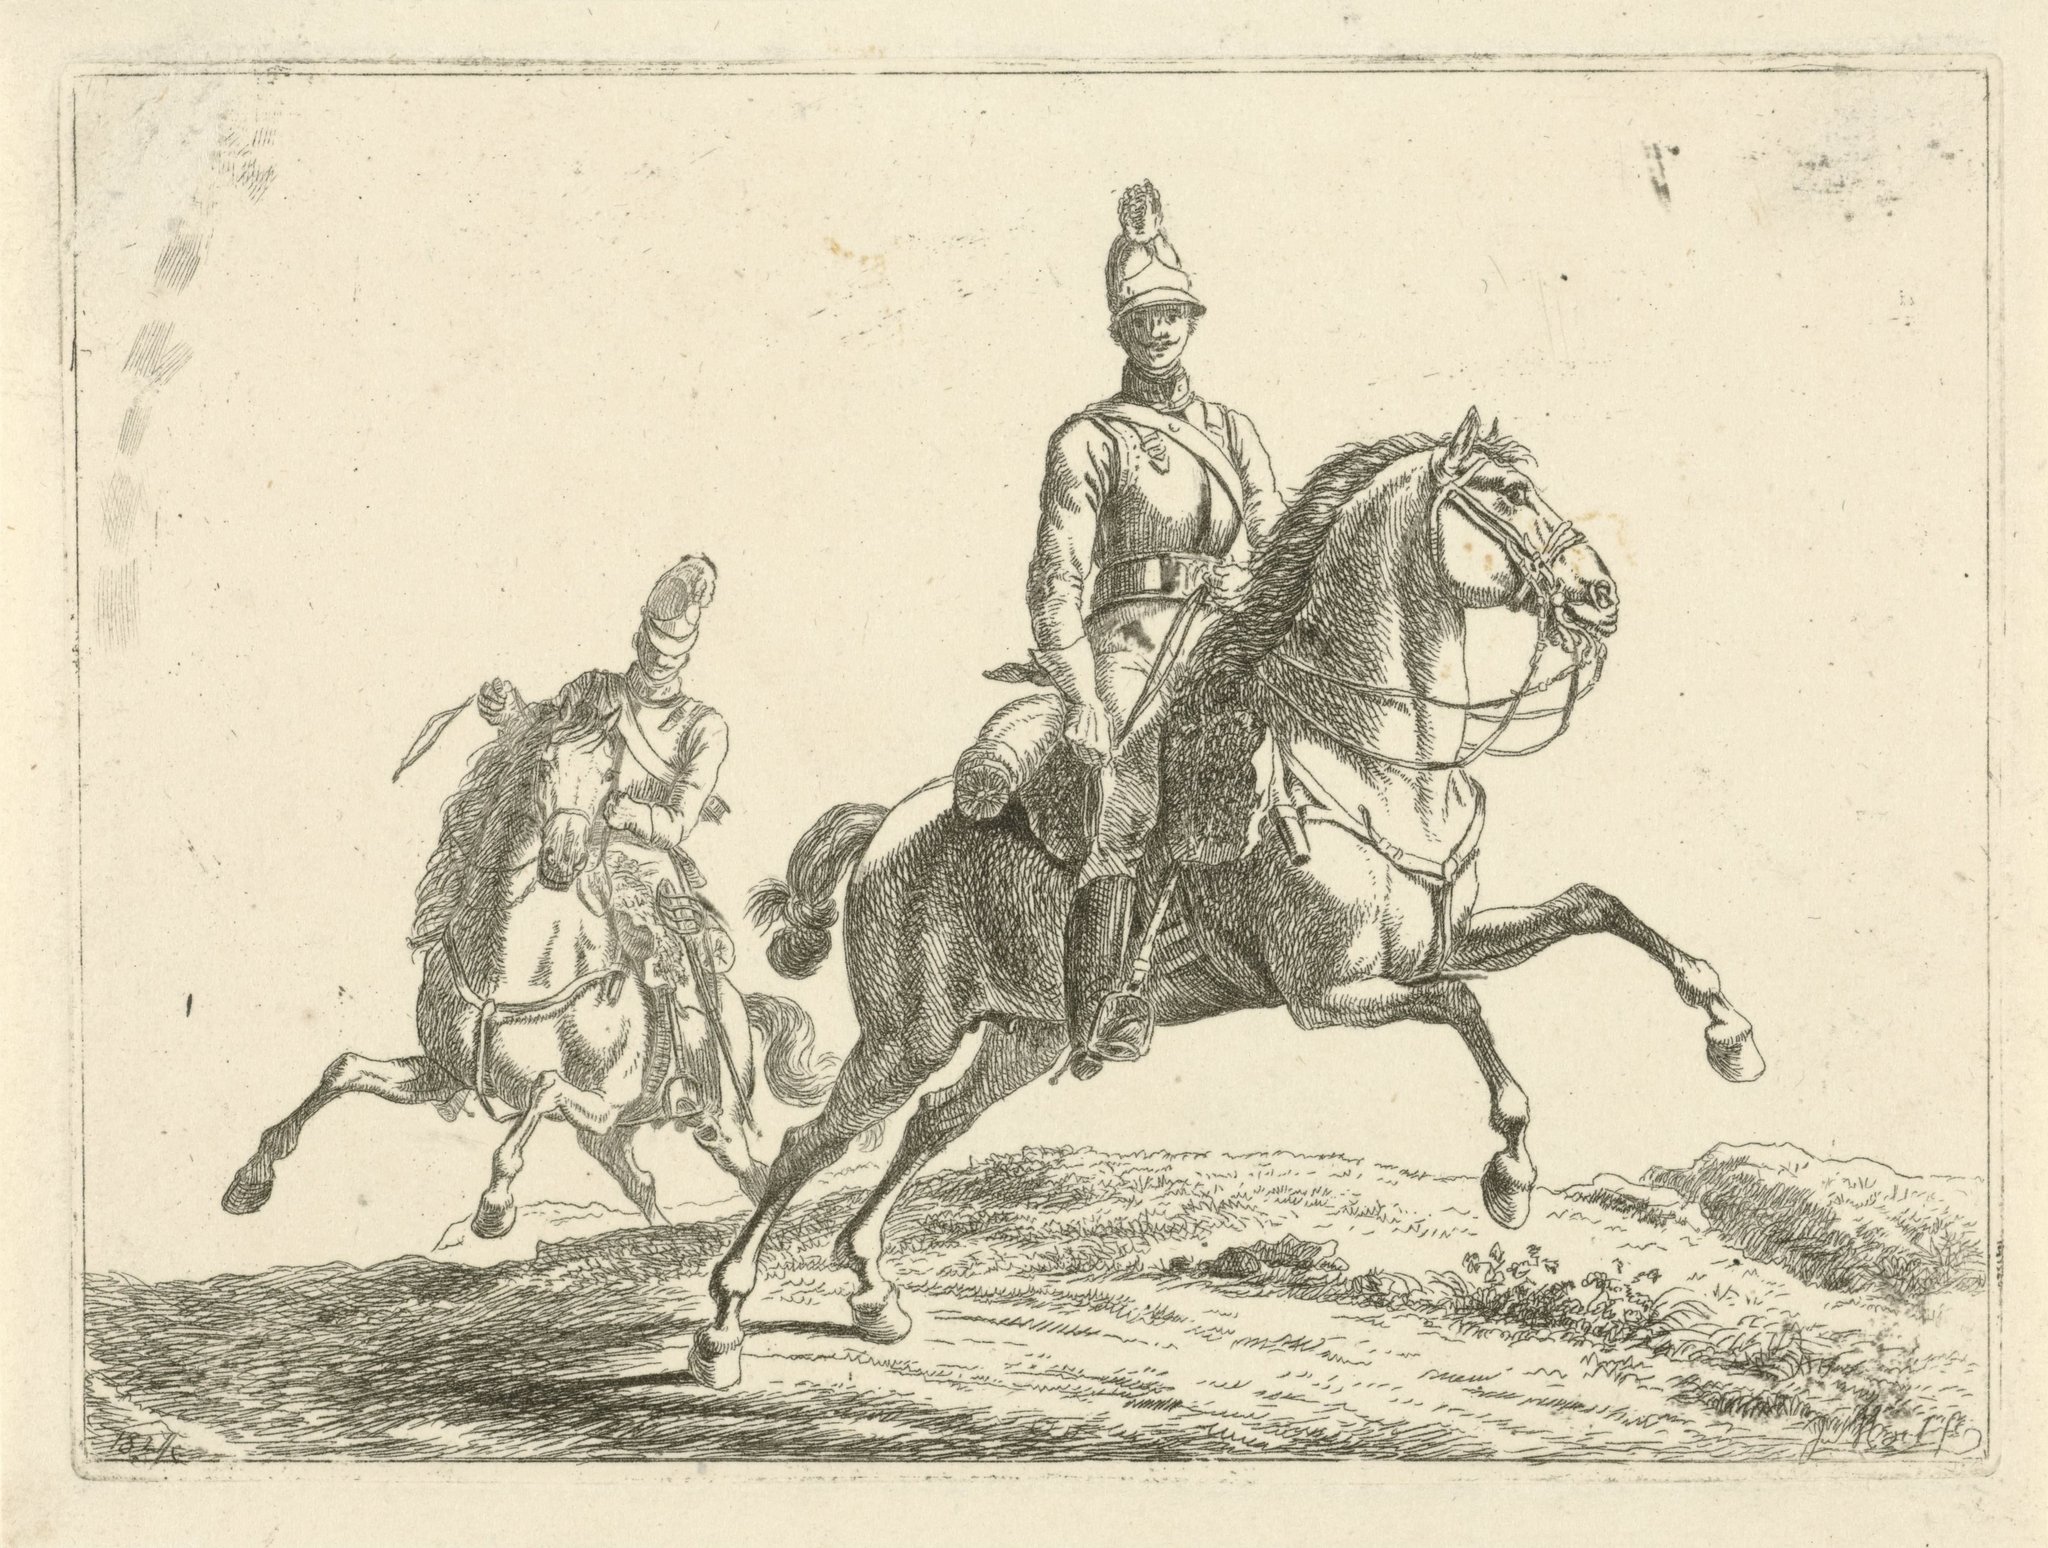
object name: print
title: Twee soldaten te paard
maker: johannes mock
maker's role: draughtsman, painter, print maker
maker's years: 1800-1884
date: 1821-1827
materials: paper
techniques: etching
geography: netherlands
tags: land forces (+ cavalry, horsemen)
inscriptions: collector's mark: Lugt 2228